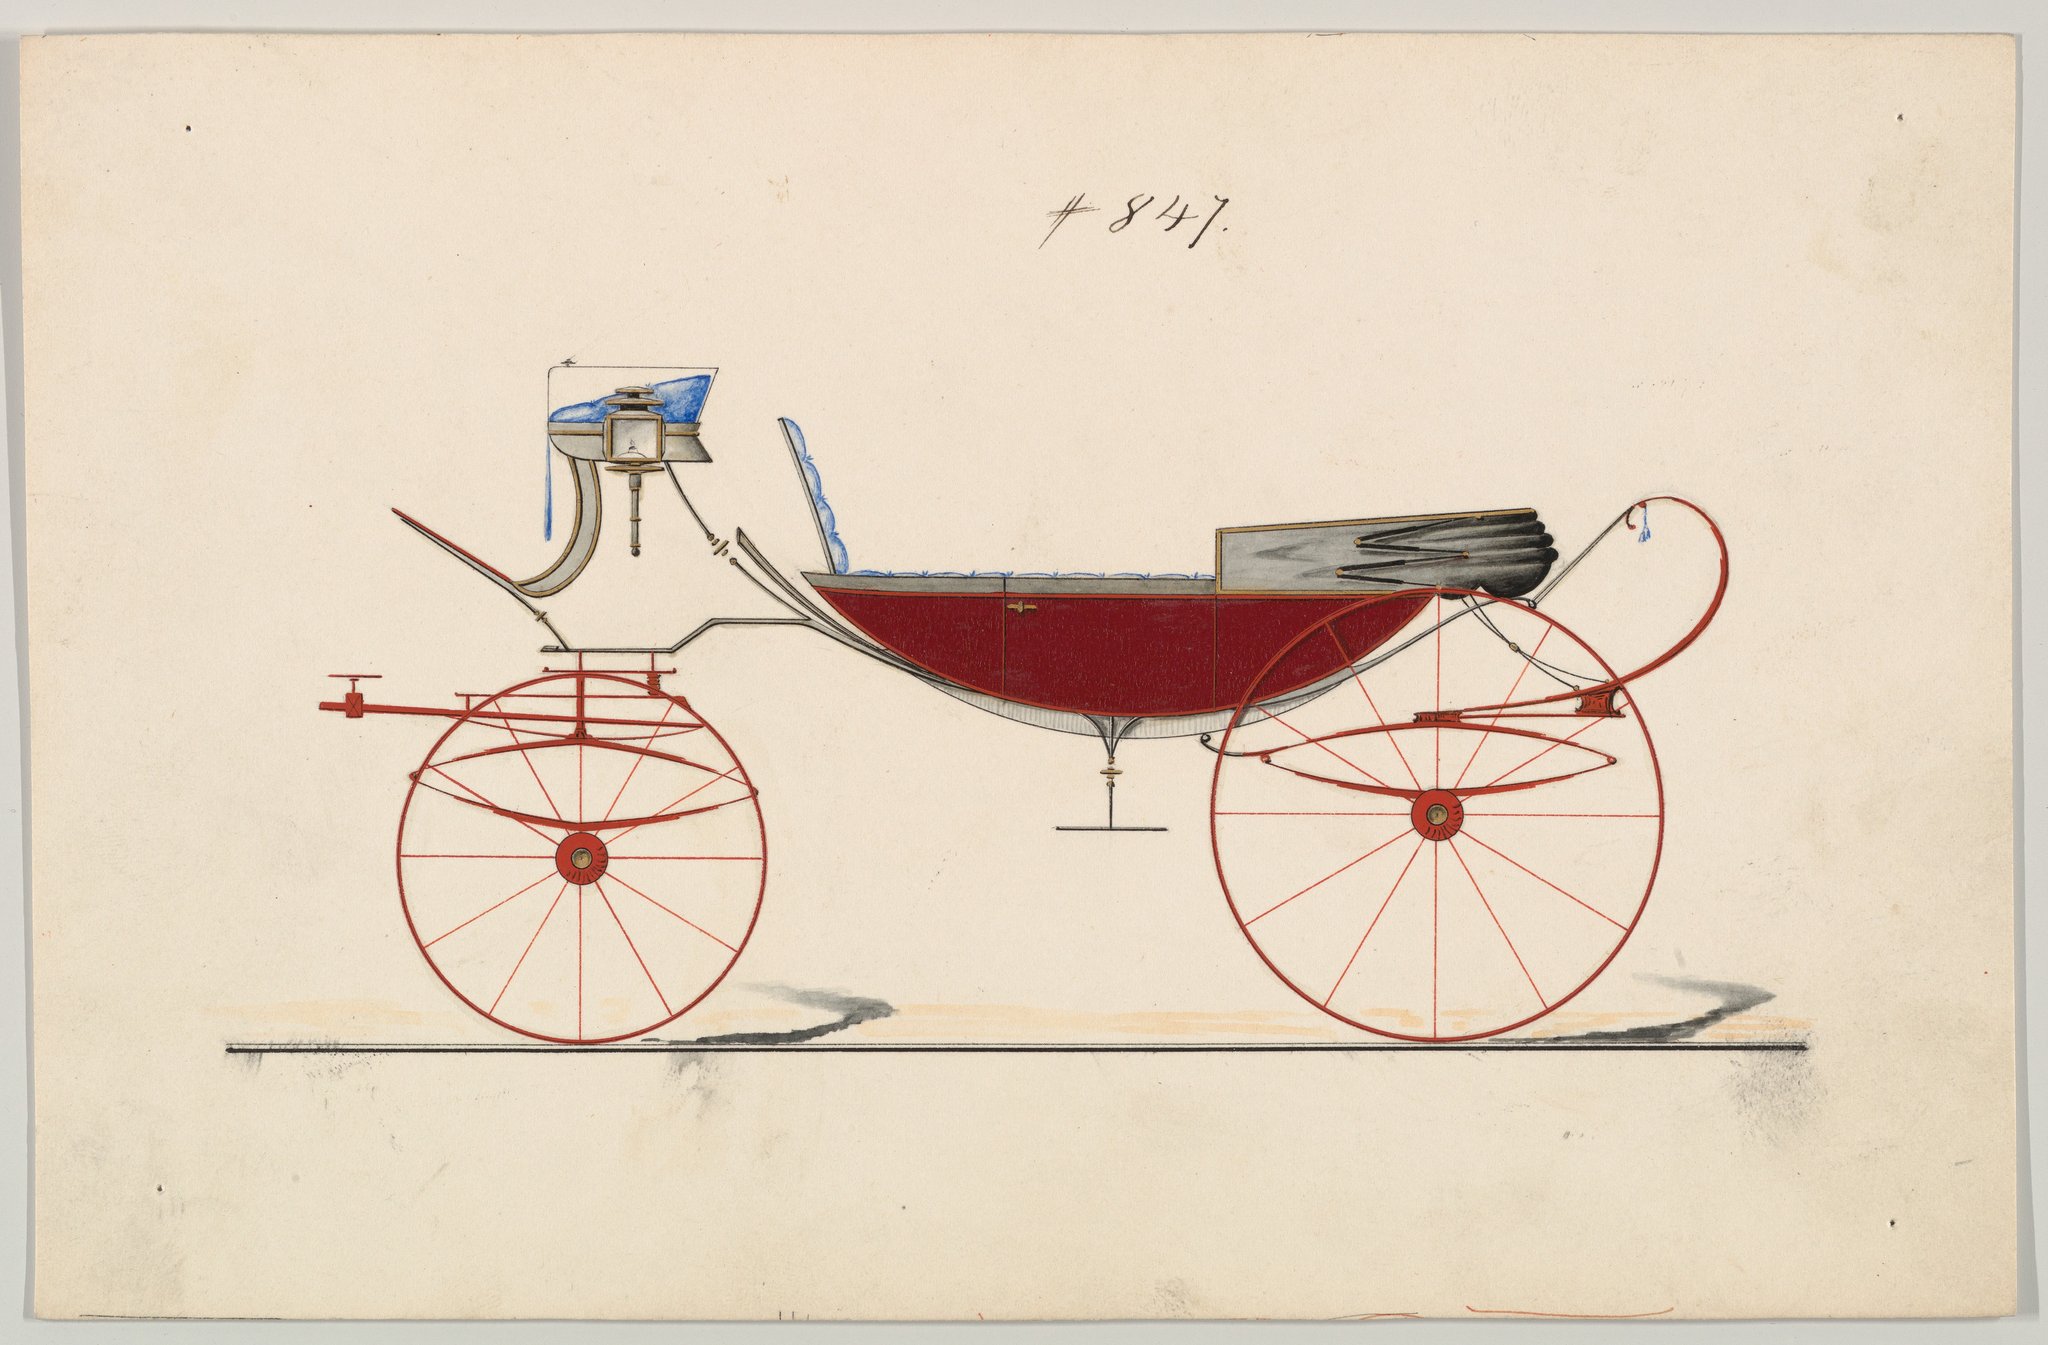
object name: drawing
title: Design for Vis-à-vis/ Caleche, no. 847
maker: brewster & co.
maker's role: manufacturer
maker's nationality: american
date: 1850-1870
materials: gouache, gum arabic, ink, watercolor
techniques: pen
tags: carriages